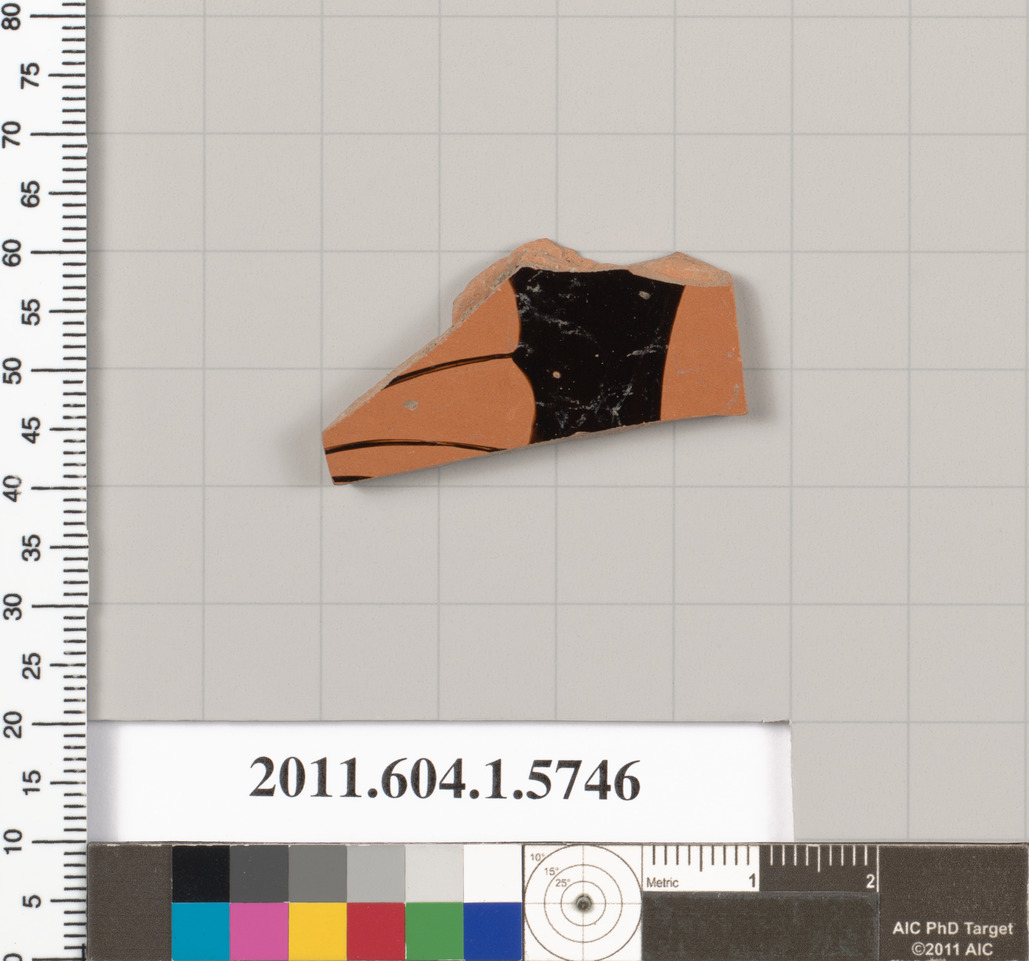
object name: kylix fragment, eye cup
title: Terracotta fragment of a kylix: eye-cup (drinking cup)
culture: greek, attic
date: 525-510 BCE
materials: terracotta